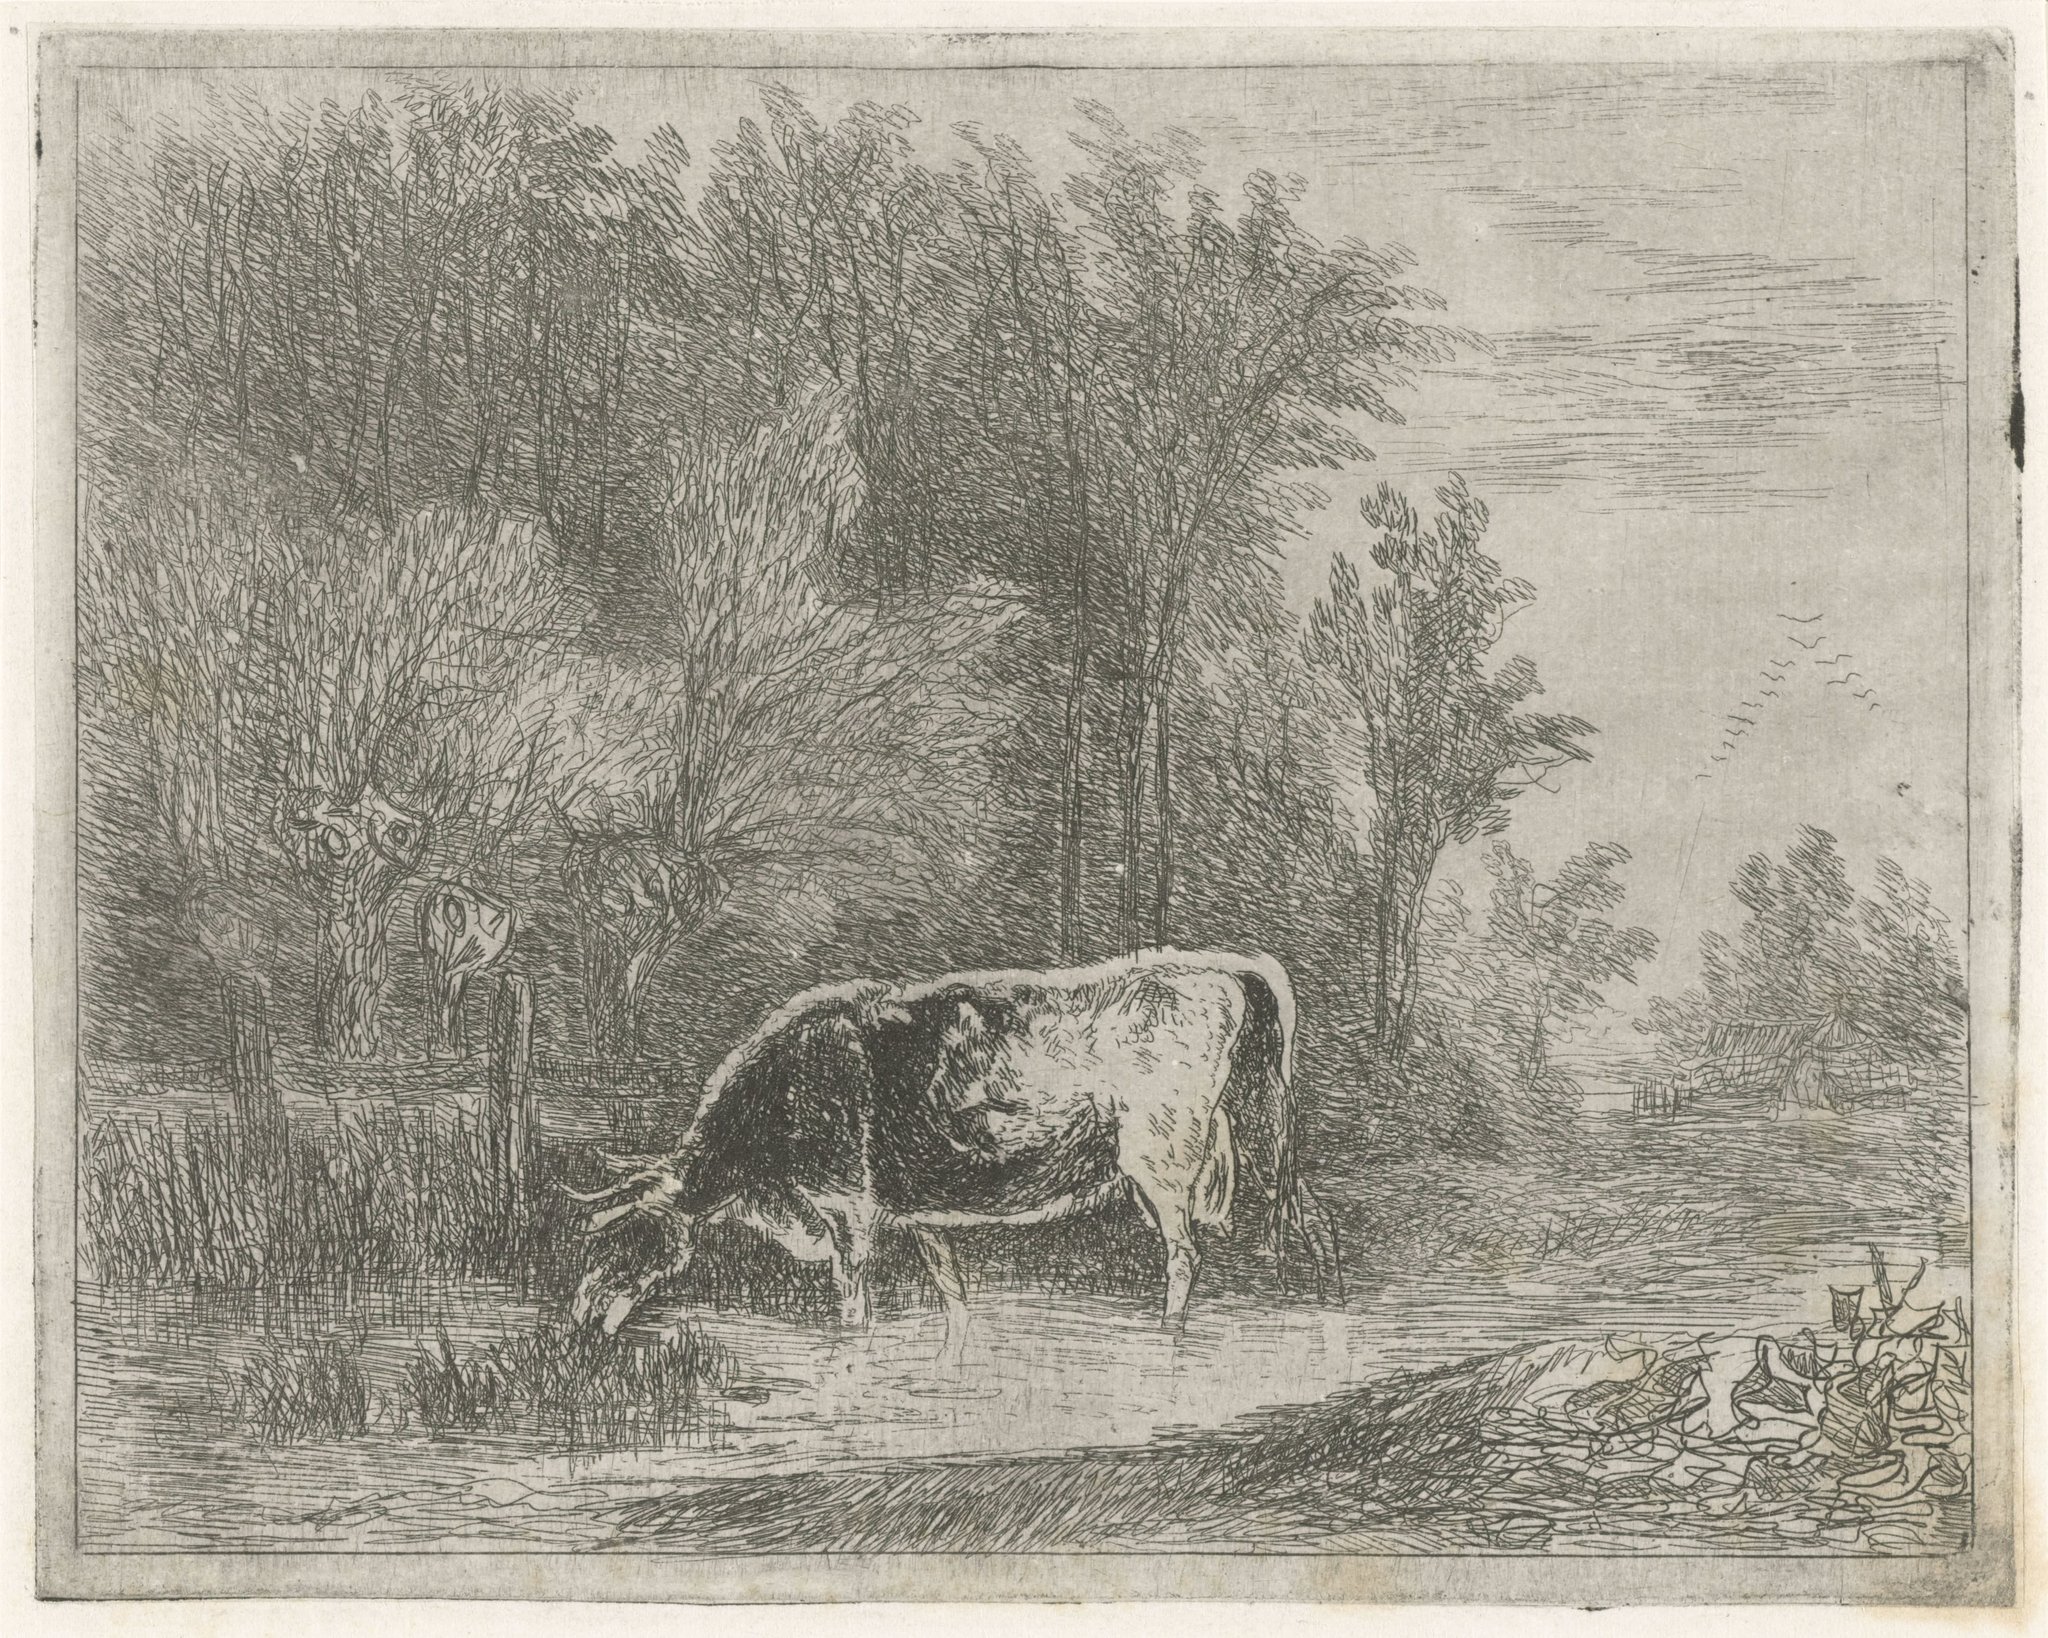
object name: print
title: Koe bij een bosrand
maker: hermanus jan hendrik van rijkelijkhuysen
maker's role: painter, print maker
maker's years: 1813-1883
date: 1823-1883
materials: paper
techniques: etching, intaglio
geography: amsterdam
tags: swamp, inland marsh, fens, cow, forest, wood, trees: willow, hut, cabin, lodge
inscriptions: collector's mark: Lugt 2228, collector's mark: Lugt 1485